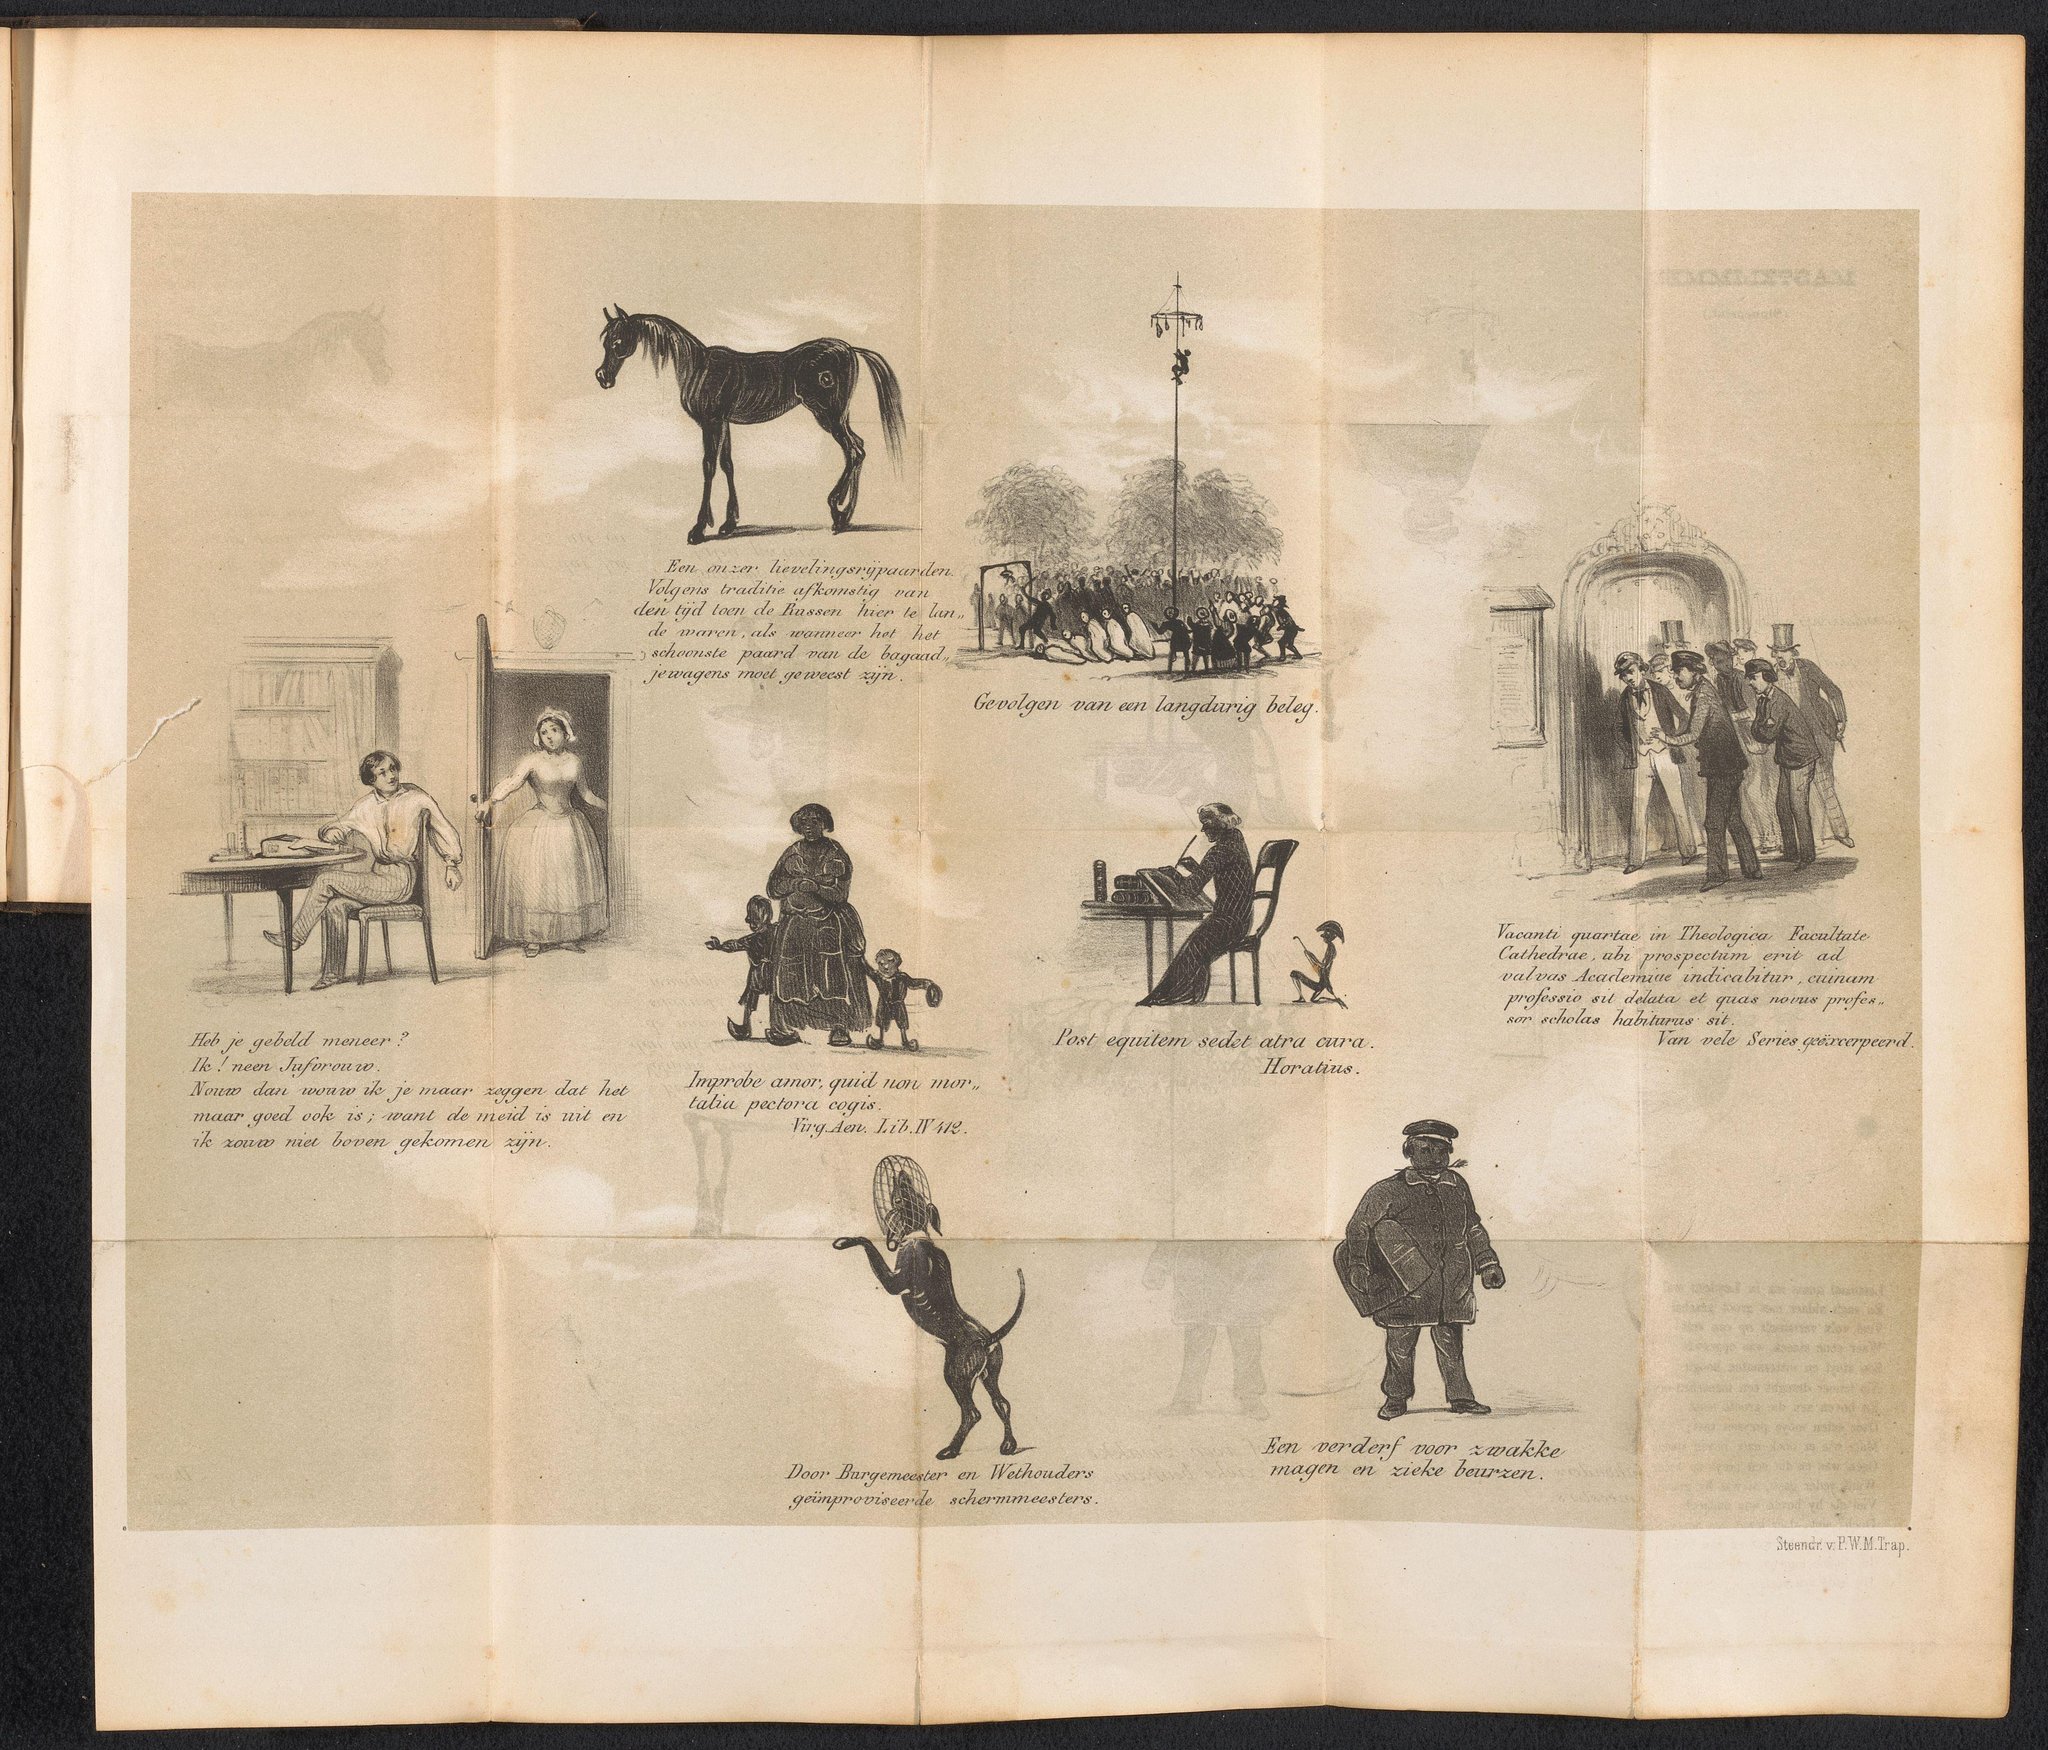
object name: cartoon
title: Spotprent in Leidse studentenalmanak, 1853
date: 1853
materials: paper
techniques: tone lithography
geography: netherlands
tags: student life, leiden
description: Spotprent met acht voorstellingen met toespelingen op het karakter van de Leidenaren. Bovenaan een uitgehongerd paard. Spotprent in de studentenalmanak van de Universiteit van Leiden van het jaar 1853.